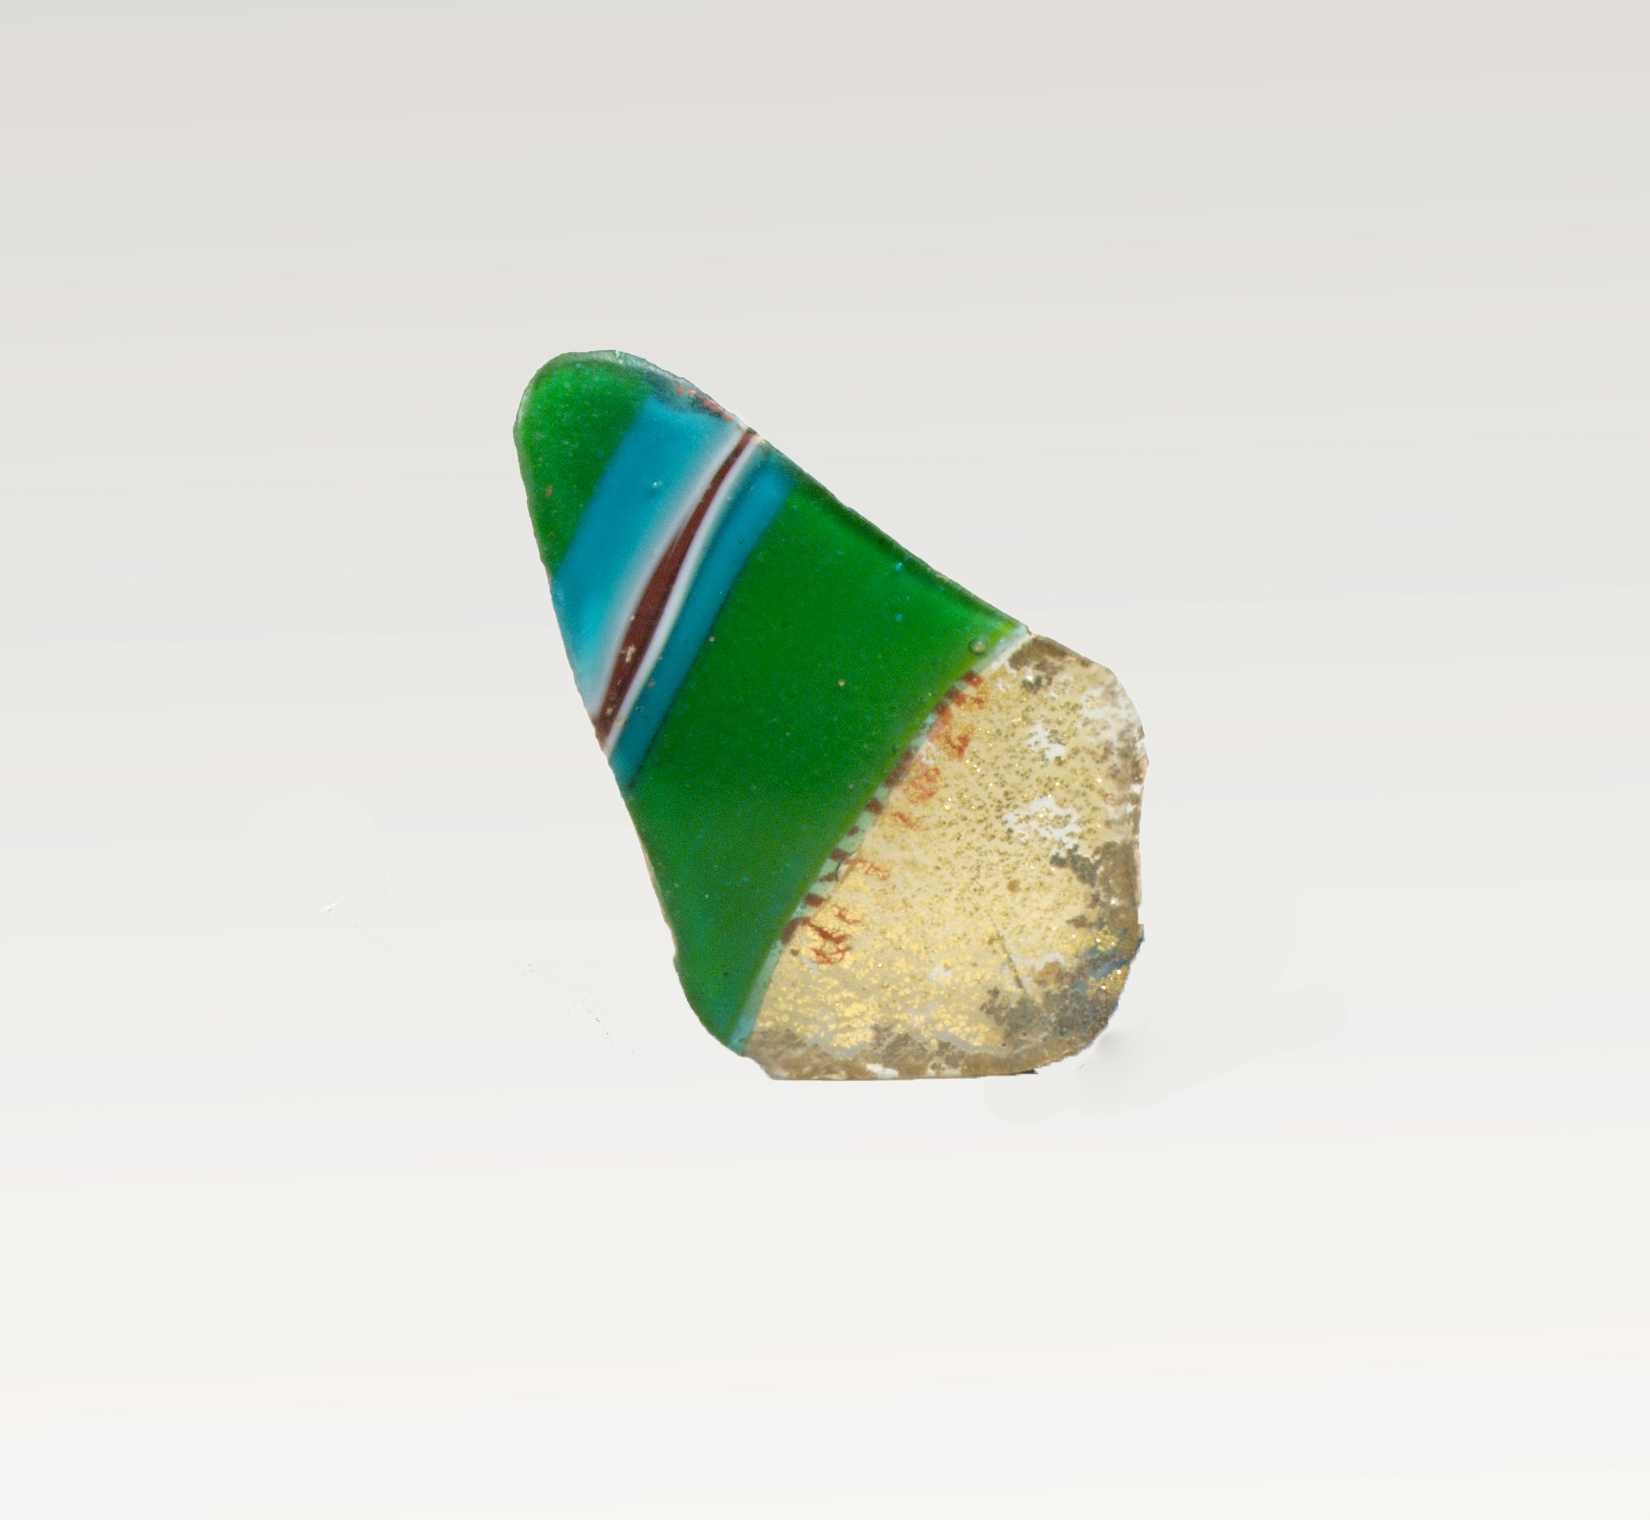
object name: fragment, gold band mosaic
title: Glass gold-band mosaic bowl fragment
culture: roman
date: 34 BCE-33 CE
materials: glass